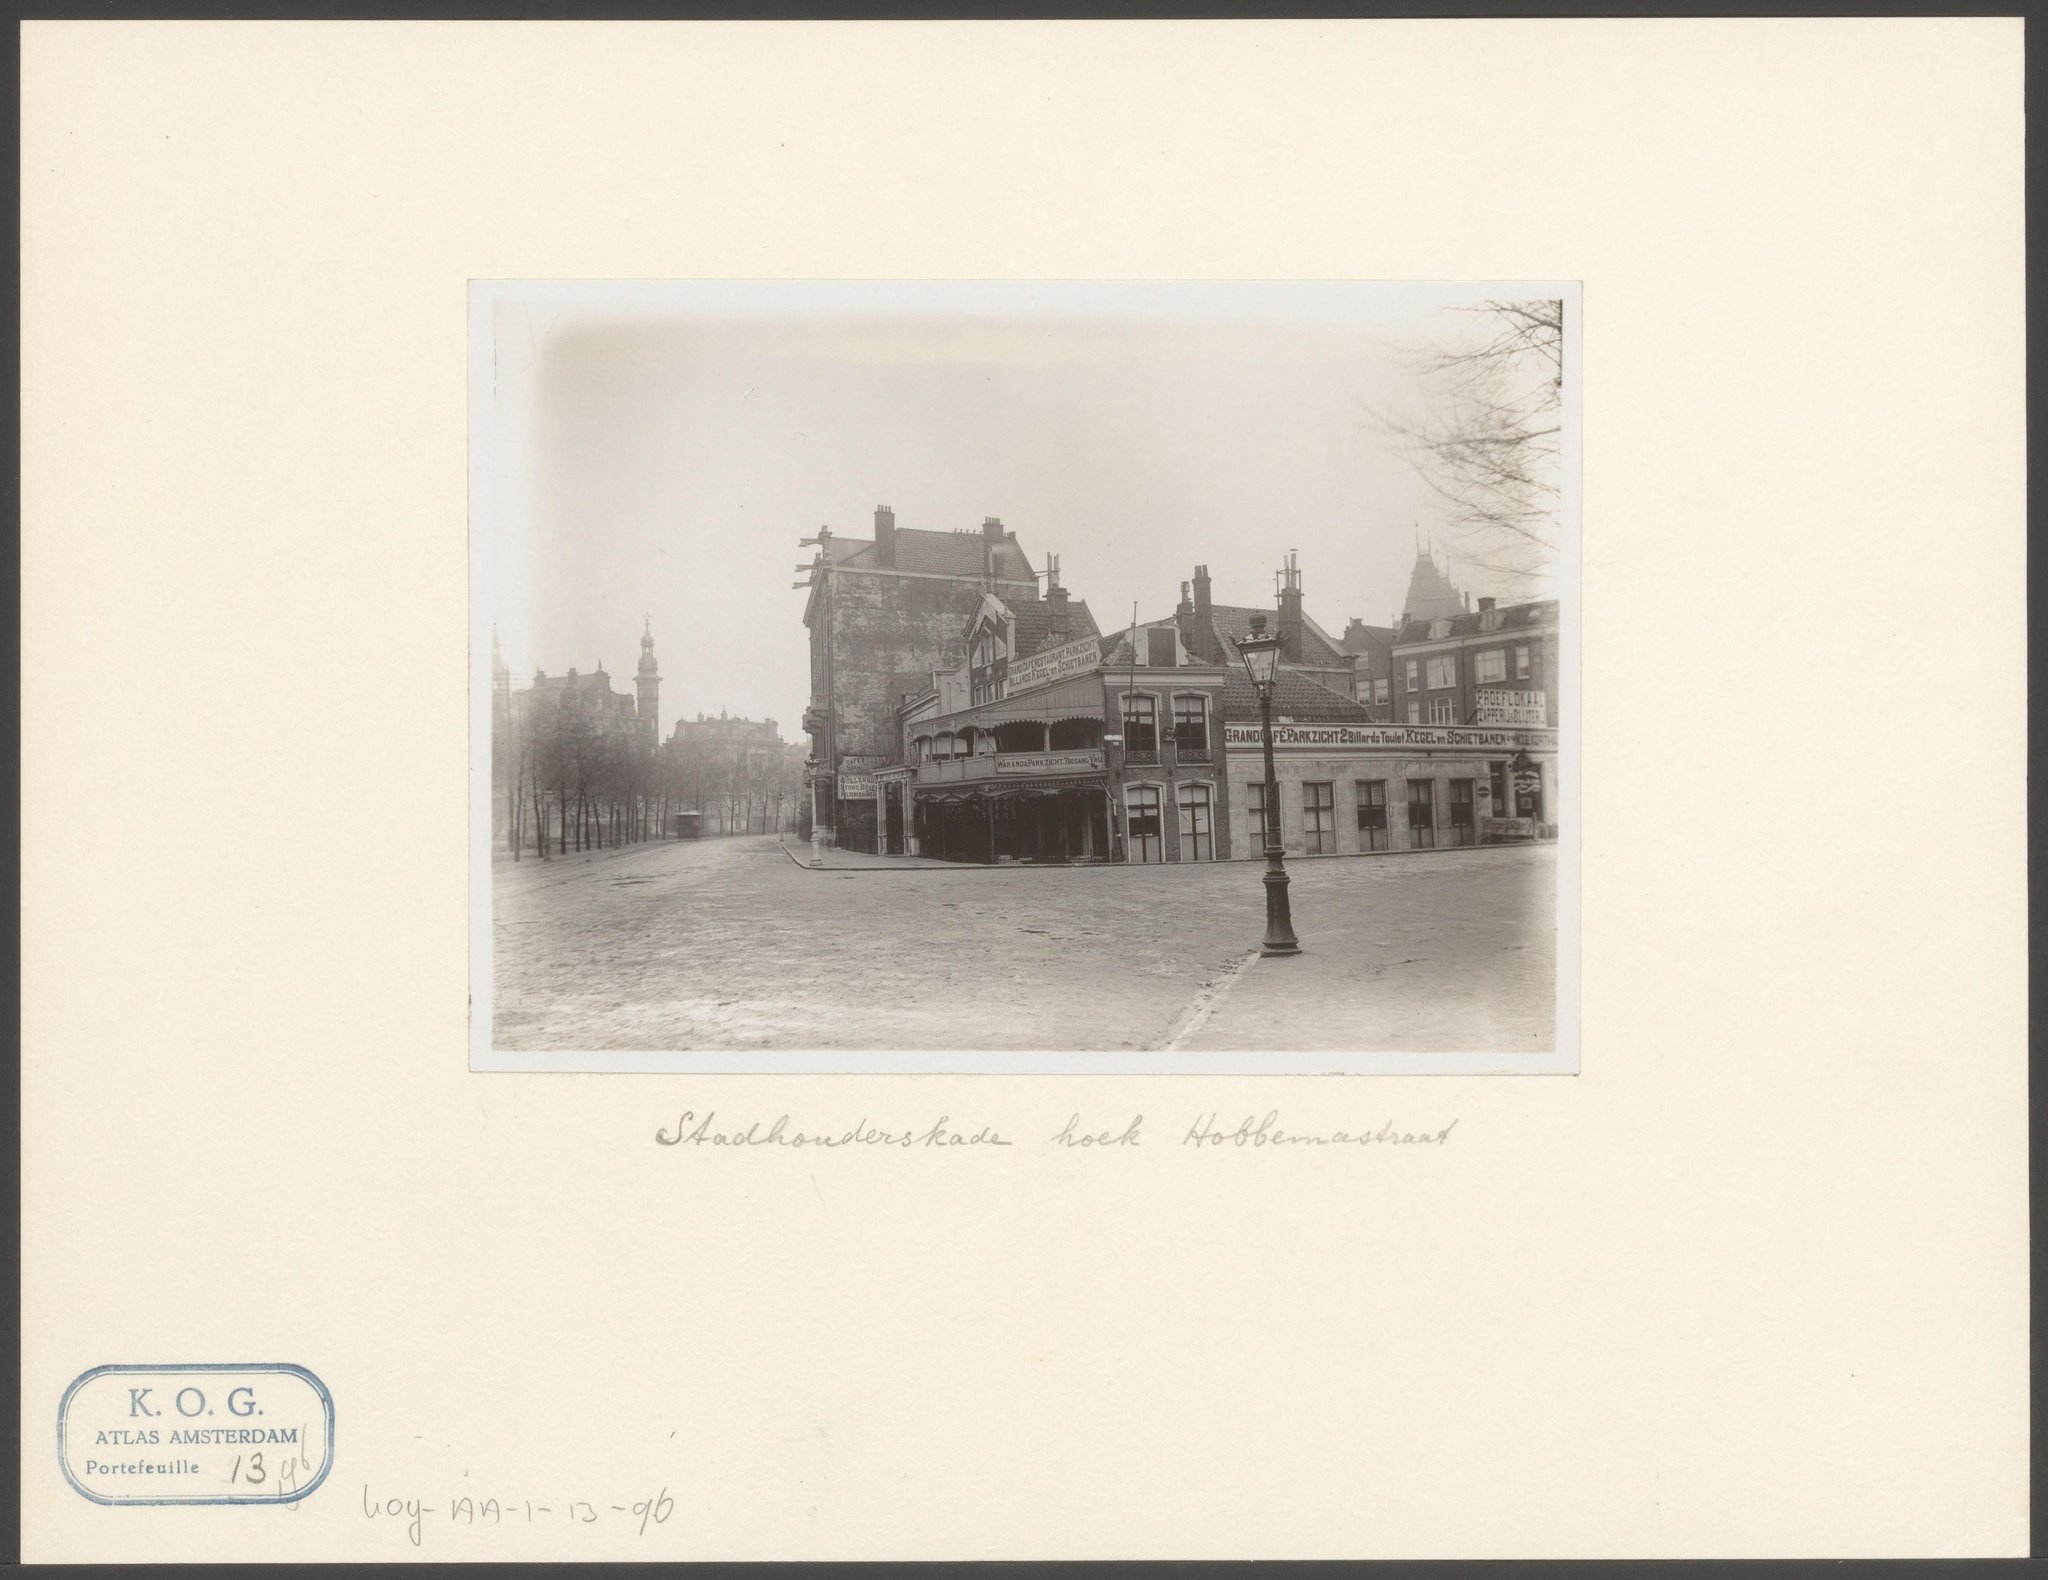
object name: photograph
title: Gezicht op de Stadhouderskade, hoek Hobbemastraat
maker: Anonymous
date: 1880-1950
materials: paper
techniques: gelatin silver print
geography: amsterdam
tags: tower, clock tower ~ monumental adornment, city-view in general; 'veduta', the usual house or row of houses, façade (of house or building), street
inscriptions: collector's mark: ‘13,96’ Lugt 1641b, inscription: ‘Stadhouderskade hoek Hobbemastraat’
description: Onderwerpsrubriek binnen de Atlas Amsterdam: Slatuinenpad, Sloterkade, Slootstraat, Slijkstraat, Snoekjesgracht, Sophiapark, Spaarndammerdijk, Spiegelgracht, Spinhuissteeg, Spui, Spuistraat (ook lage Erf), Staalstraat, Stadhouderskade, Steenpad, Stroomarkt.